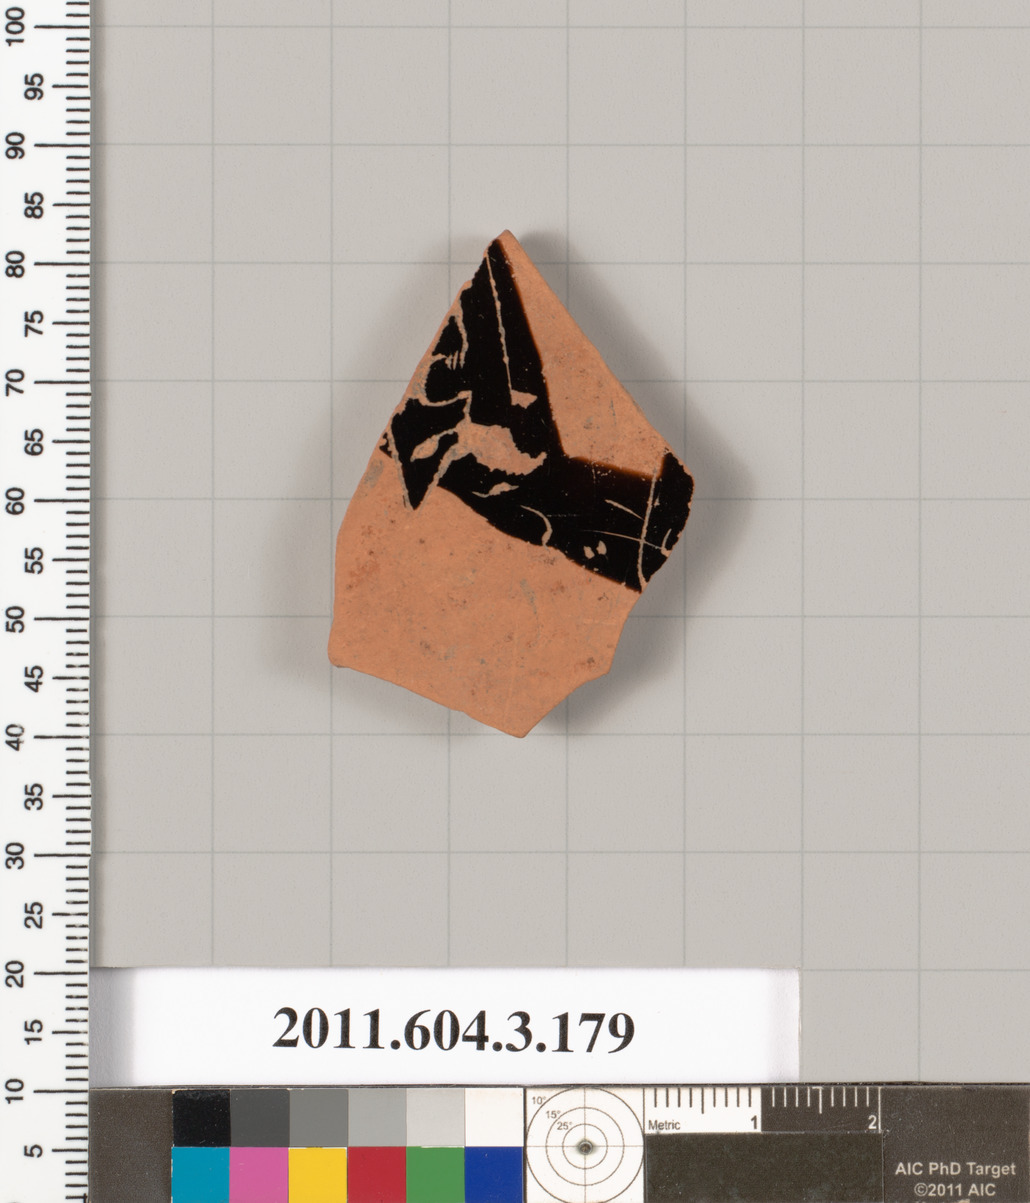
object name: amphora fragment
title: Terracotta fragment of an amphora (jar)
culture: greek, attic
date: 525-501 BCE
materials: terracotta